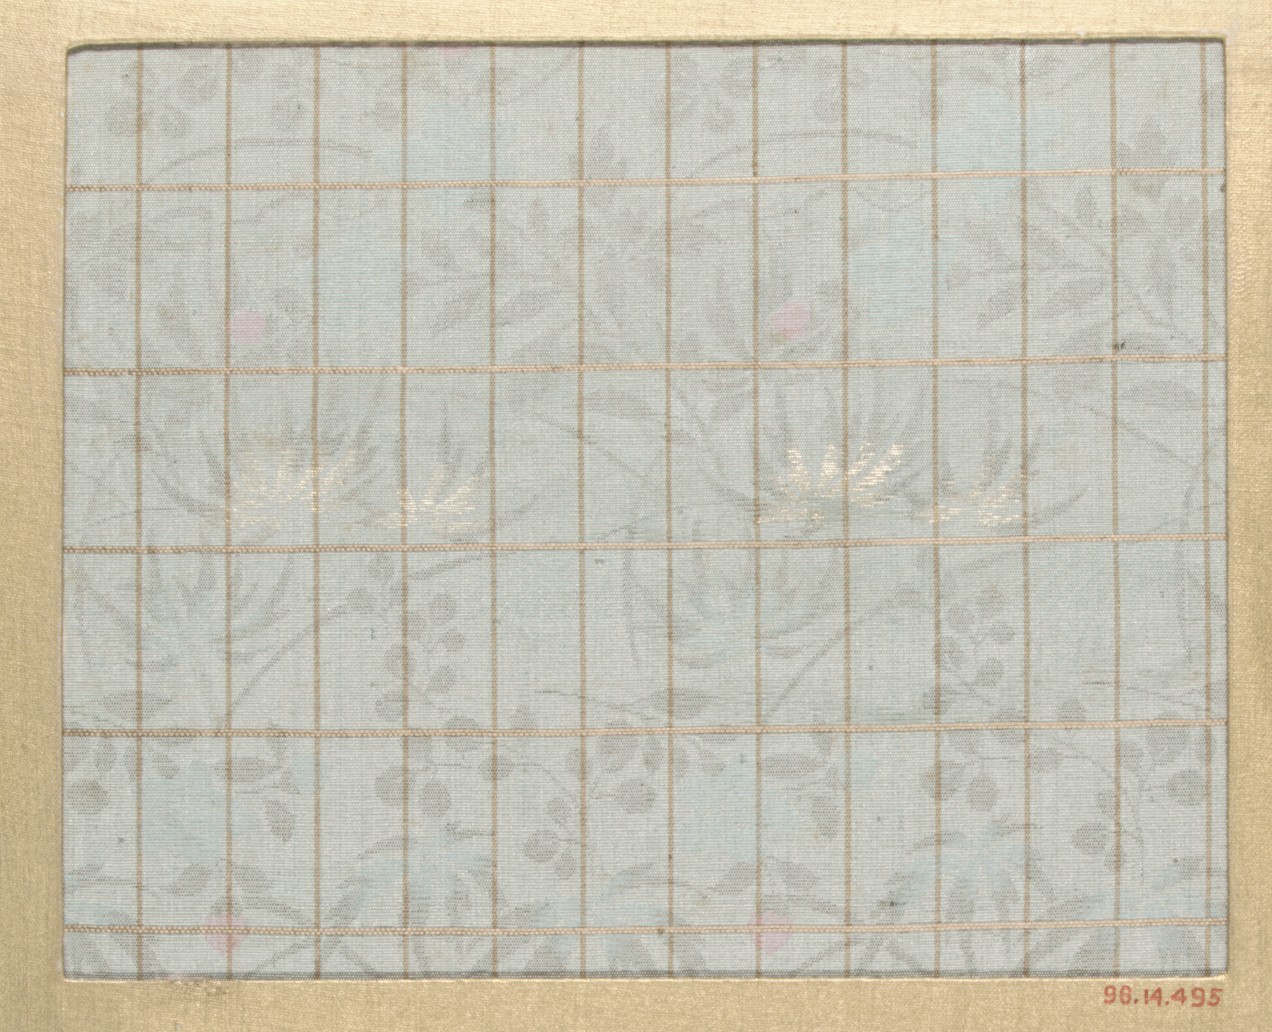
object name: piece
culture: japanese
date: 1701-1900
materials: silk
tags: leaves